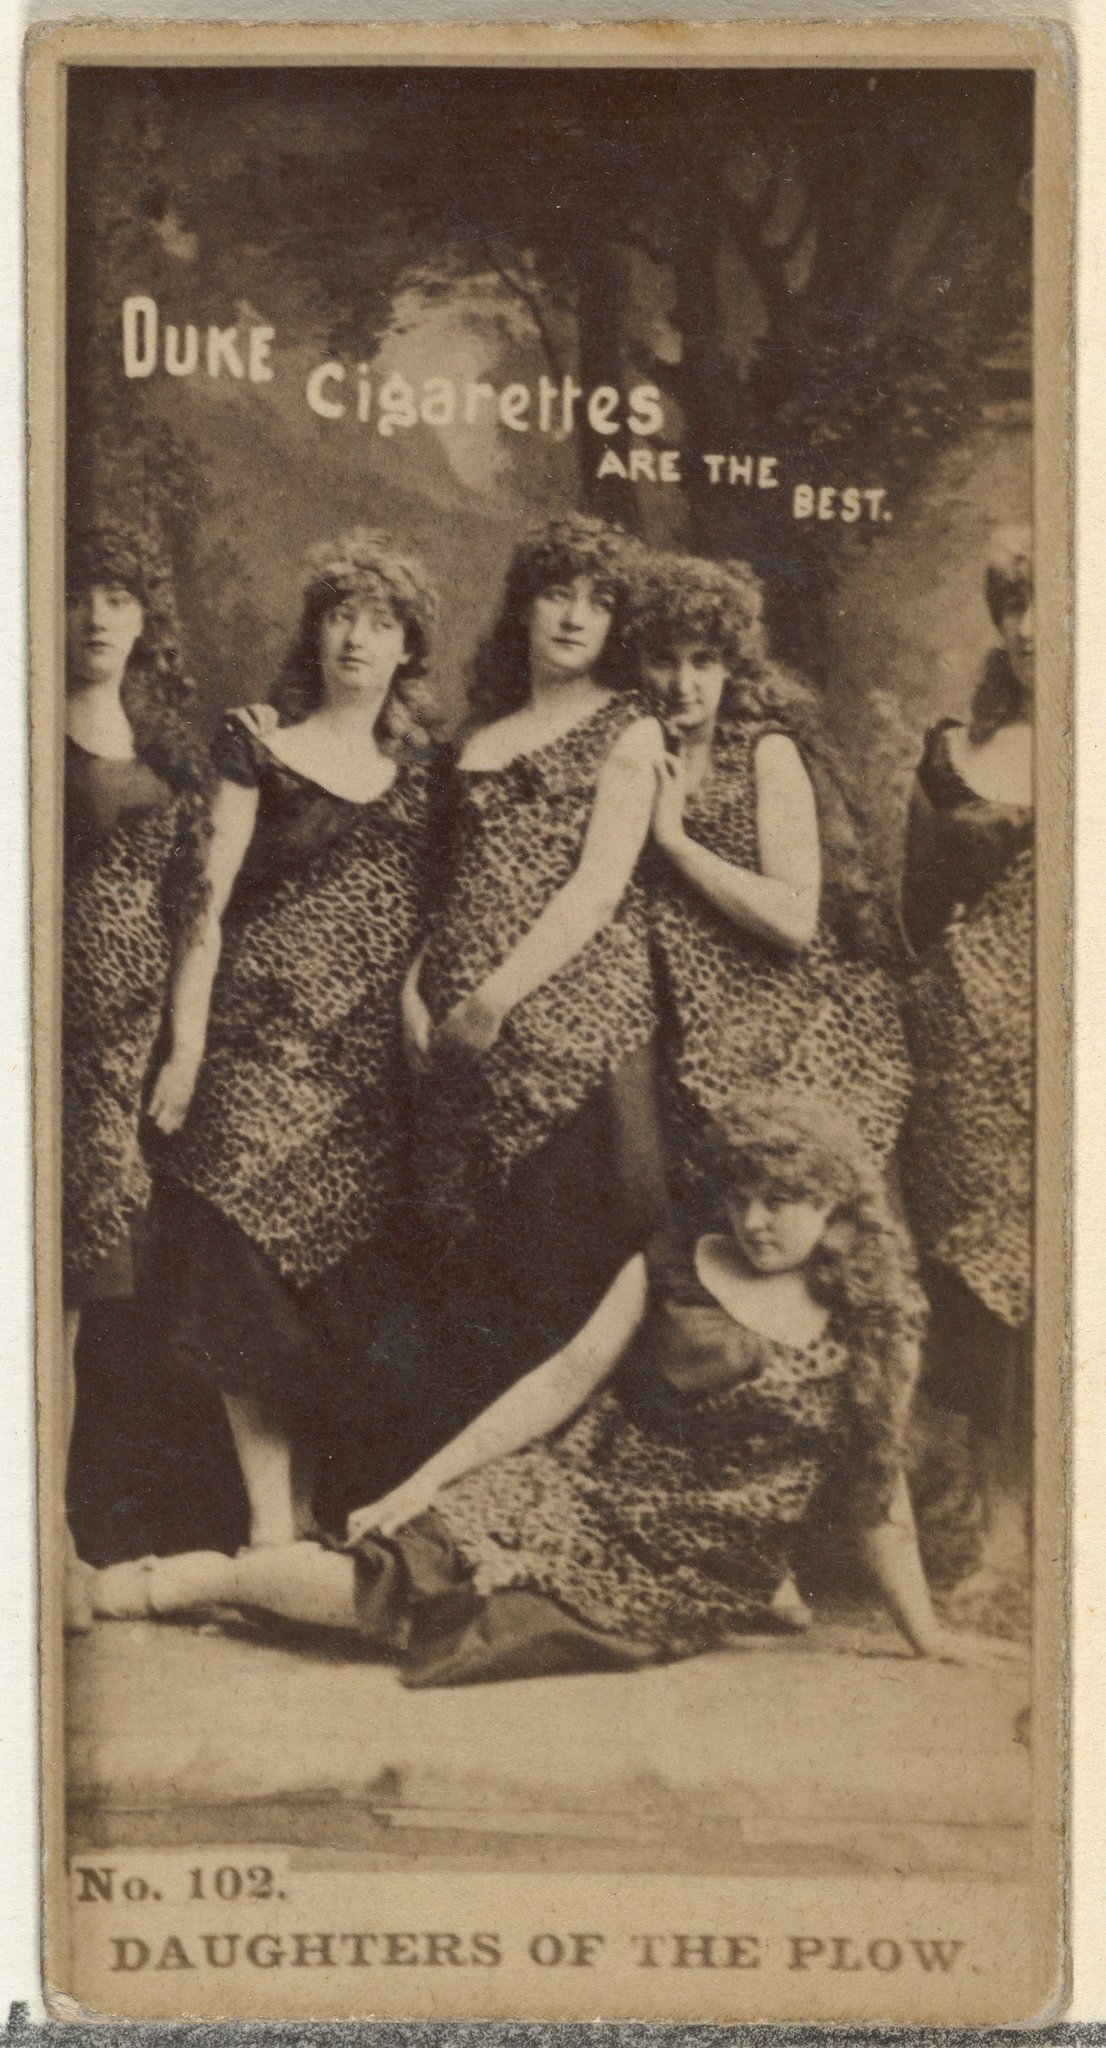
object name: photograph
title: Card Number 102, Daughters of the Plow, from the Actors and Actresses series (N145-6) issued by Duke Sons & Co. to promote Duke Cigarettes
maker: w. duke, sons & co.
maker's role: publisher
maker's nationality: american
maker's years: 1870-1920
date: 1880-1889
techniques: albumen silver print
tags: portraits,women,actresses